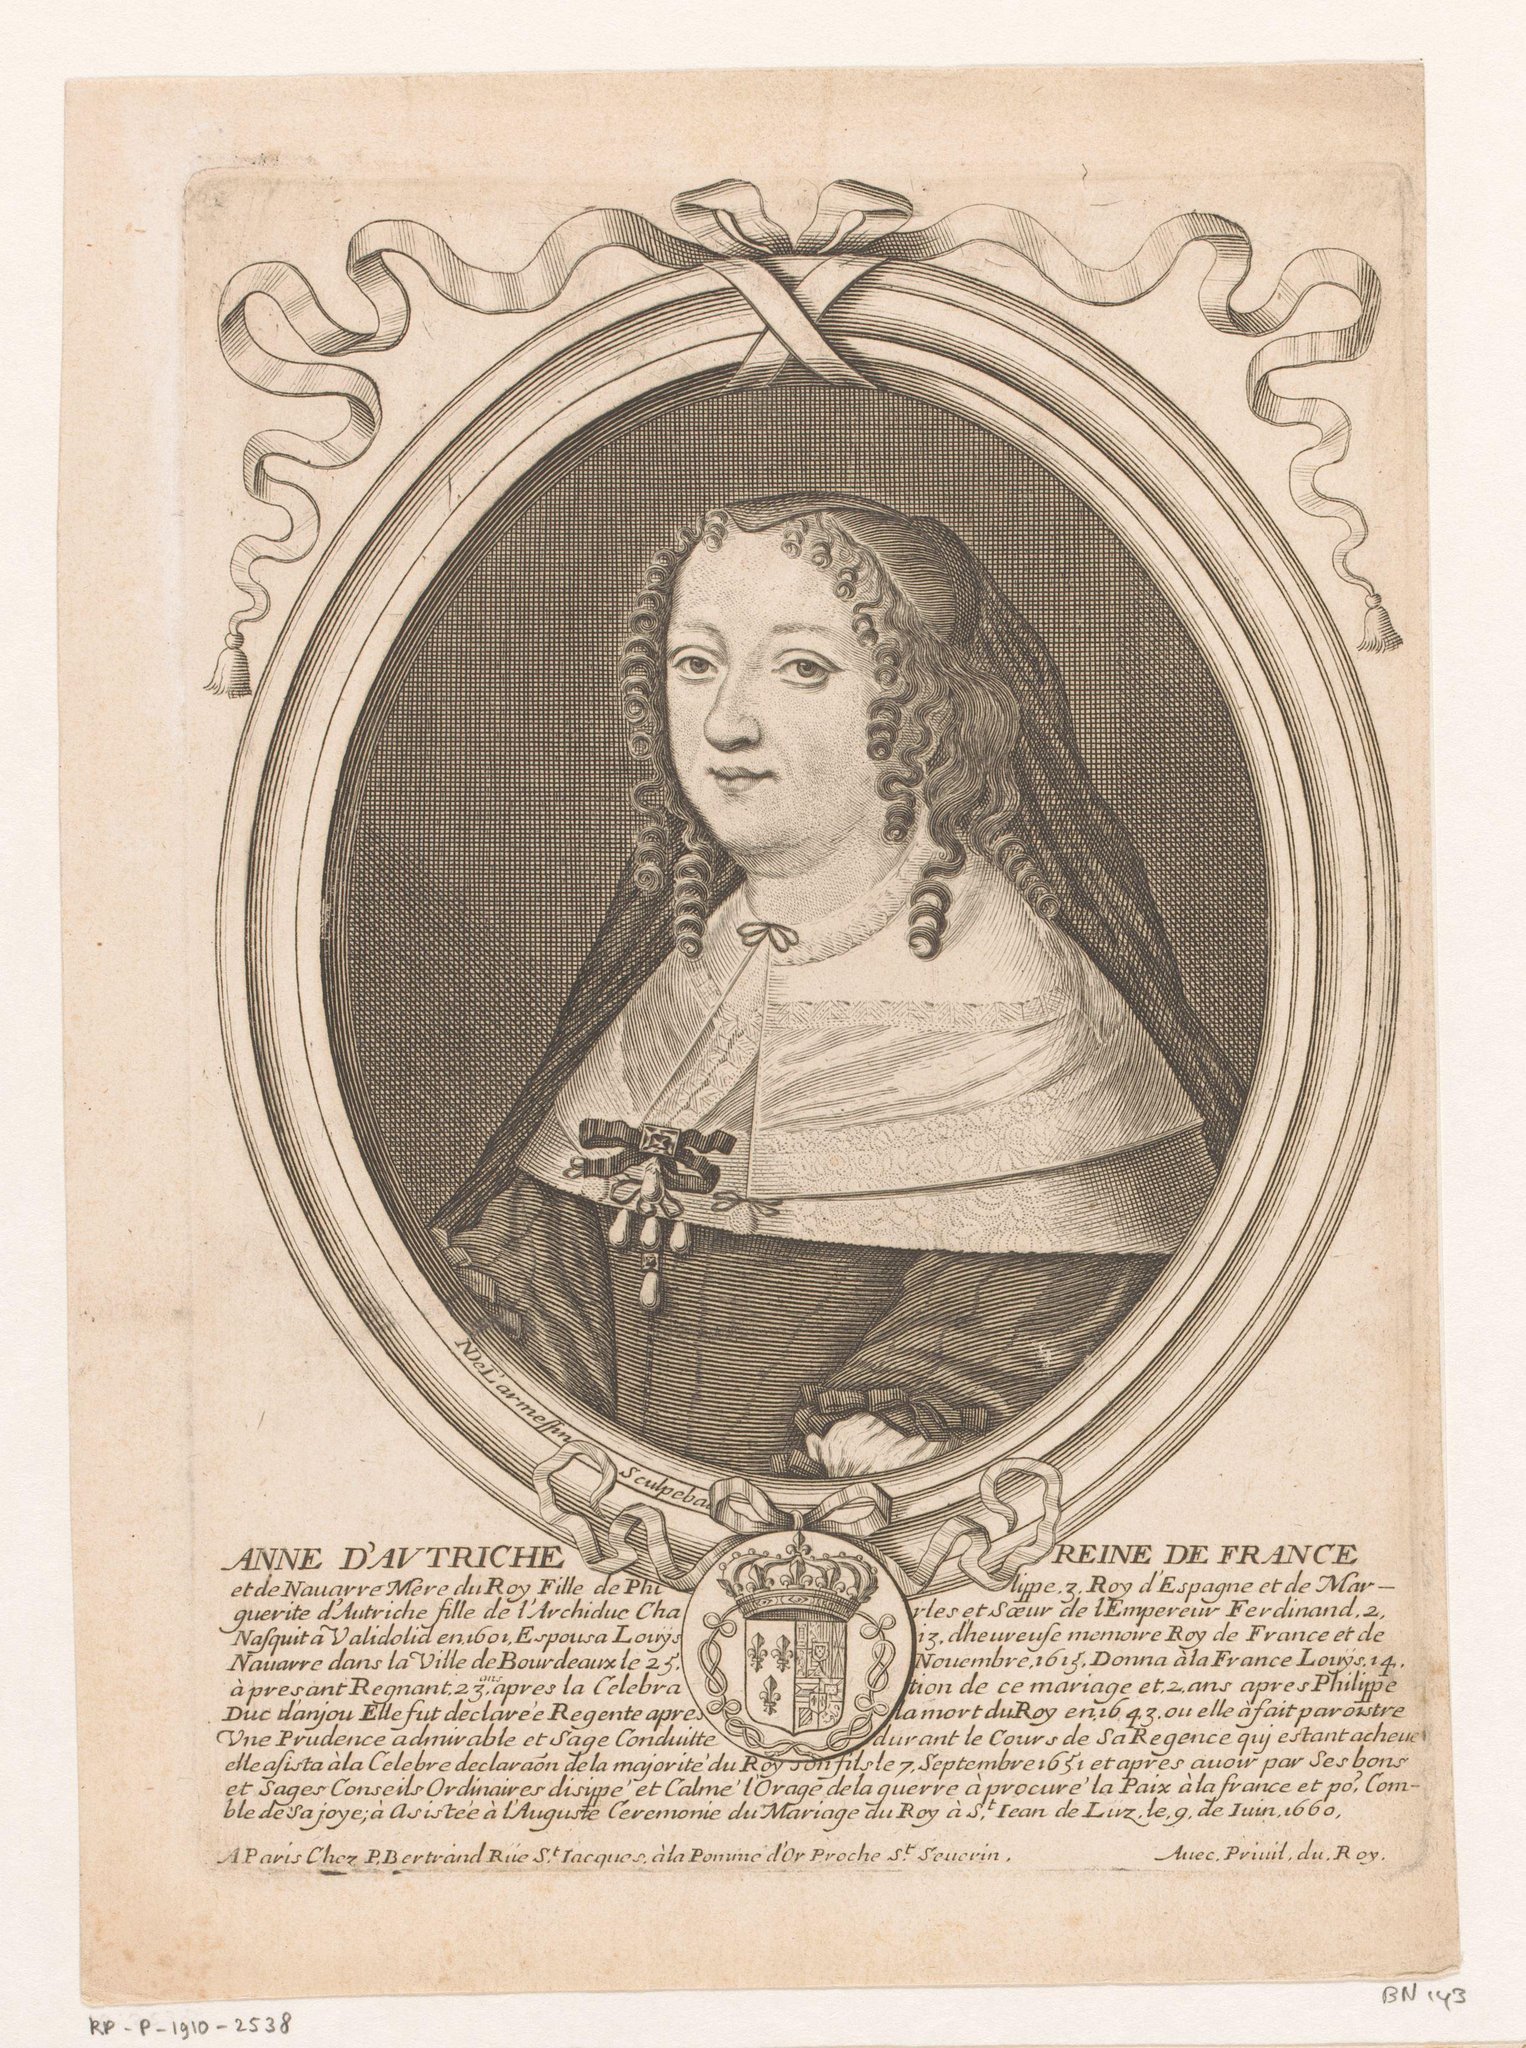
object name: print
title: Portret van Anna van Oostenrijk, koningin van Frankrijk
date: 1642-1678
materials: paper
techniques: engraving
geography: paris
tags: anna van oostenrijk (koningin van frankrijk), historical persons, queen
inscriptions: collector's mark: Lugt 2228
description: Maakt deel uit van een grootschalige serie met portretten van prominente figuren. Binnen de serie bevindt zich een sectie getiteld 'Les Augustes Représentations De tous les Roys De France depuis Pharamond Iusqu'à Louys XIIII'. De serie werd respectievelijk uitgegeven door Pierre Bertrand, door zijn weduwe en door De Larmessin zelf.